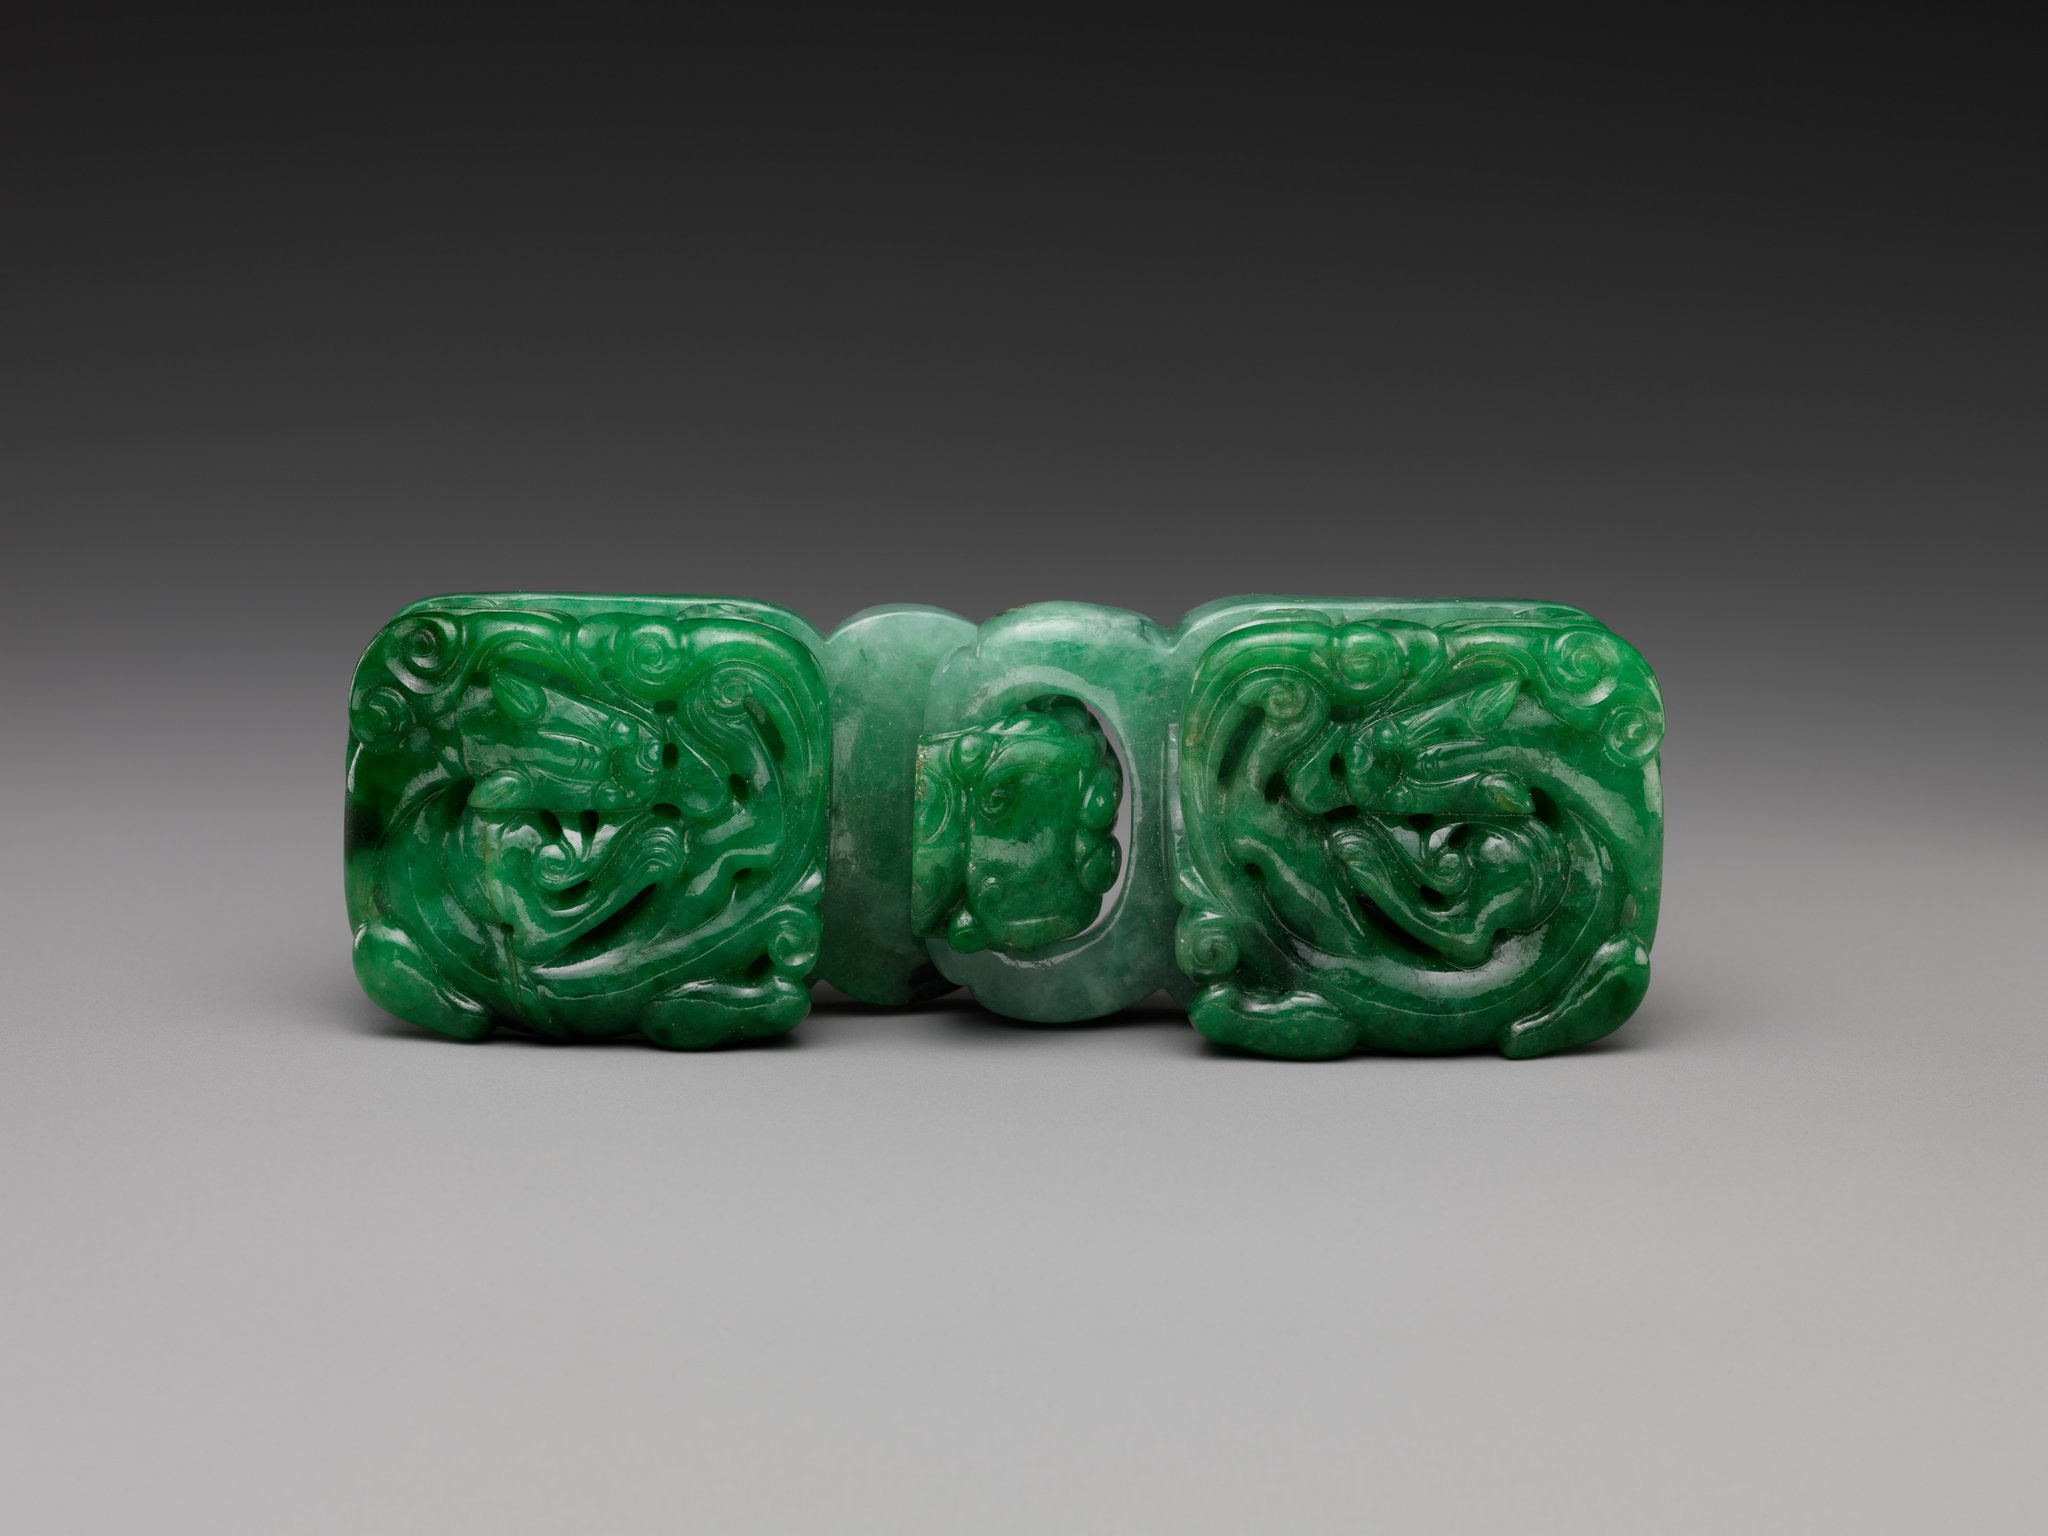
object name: belt buckle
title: Belt buckle with dragons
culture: chinese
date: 1801-1900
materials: jade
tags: dragons